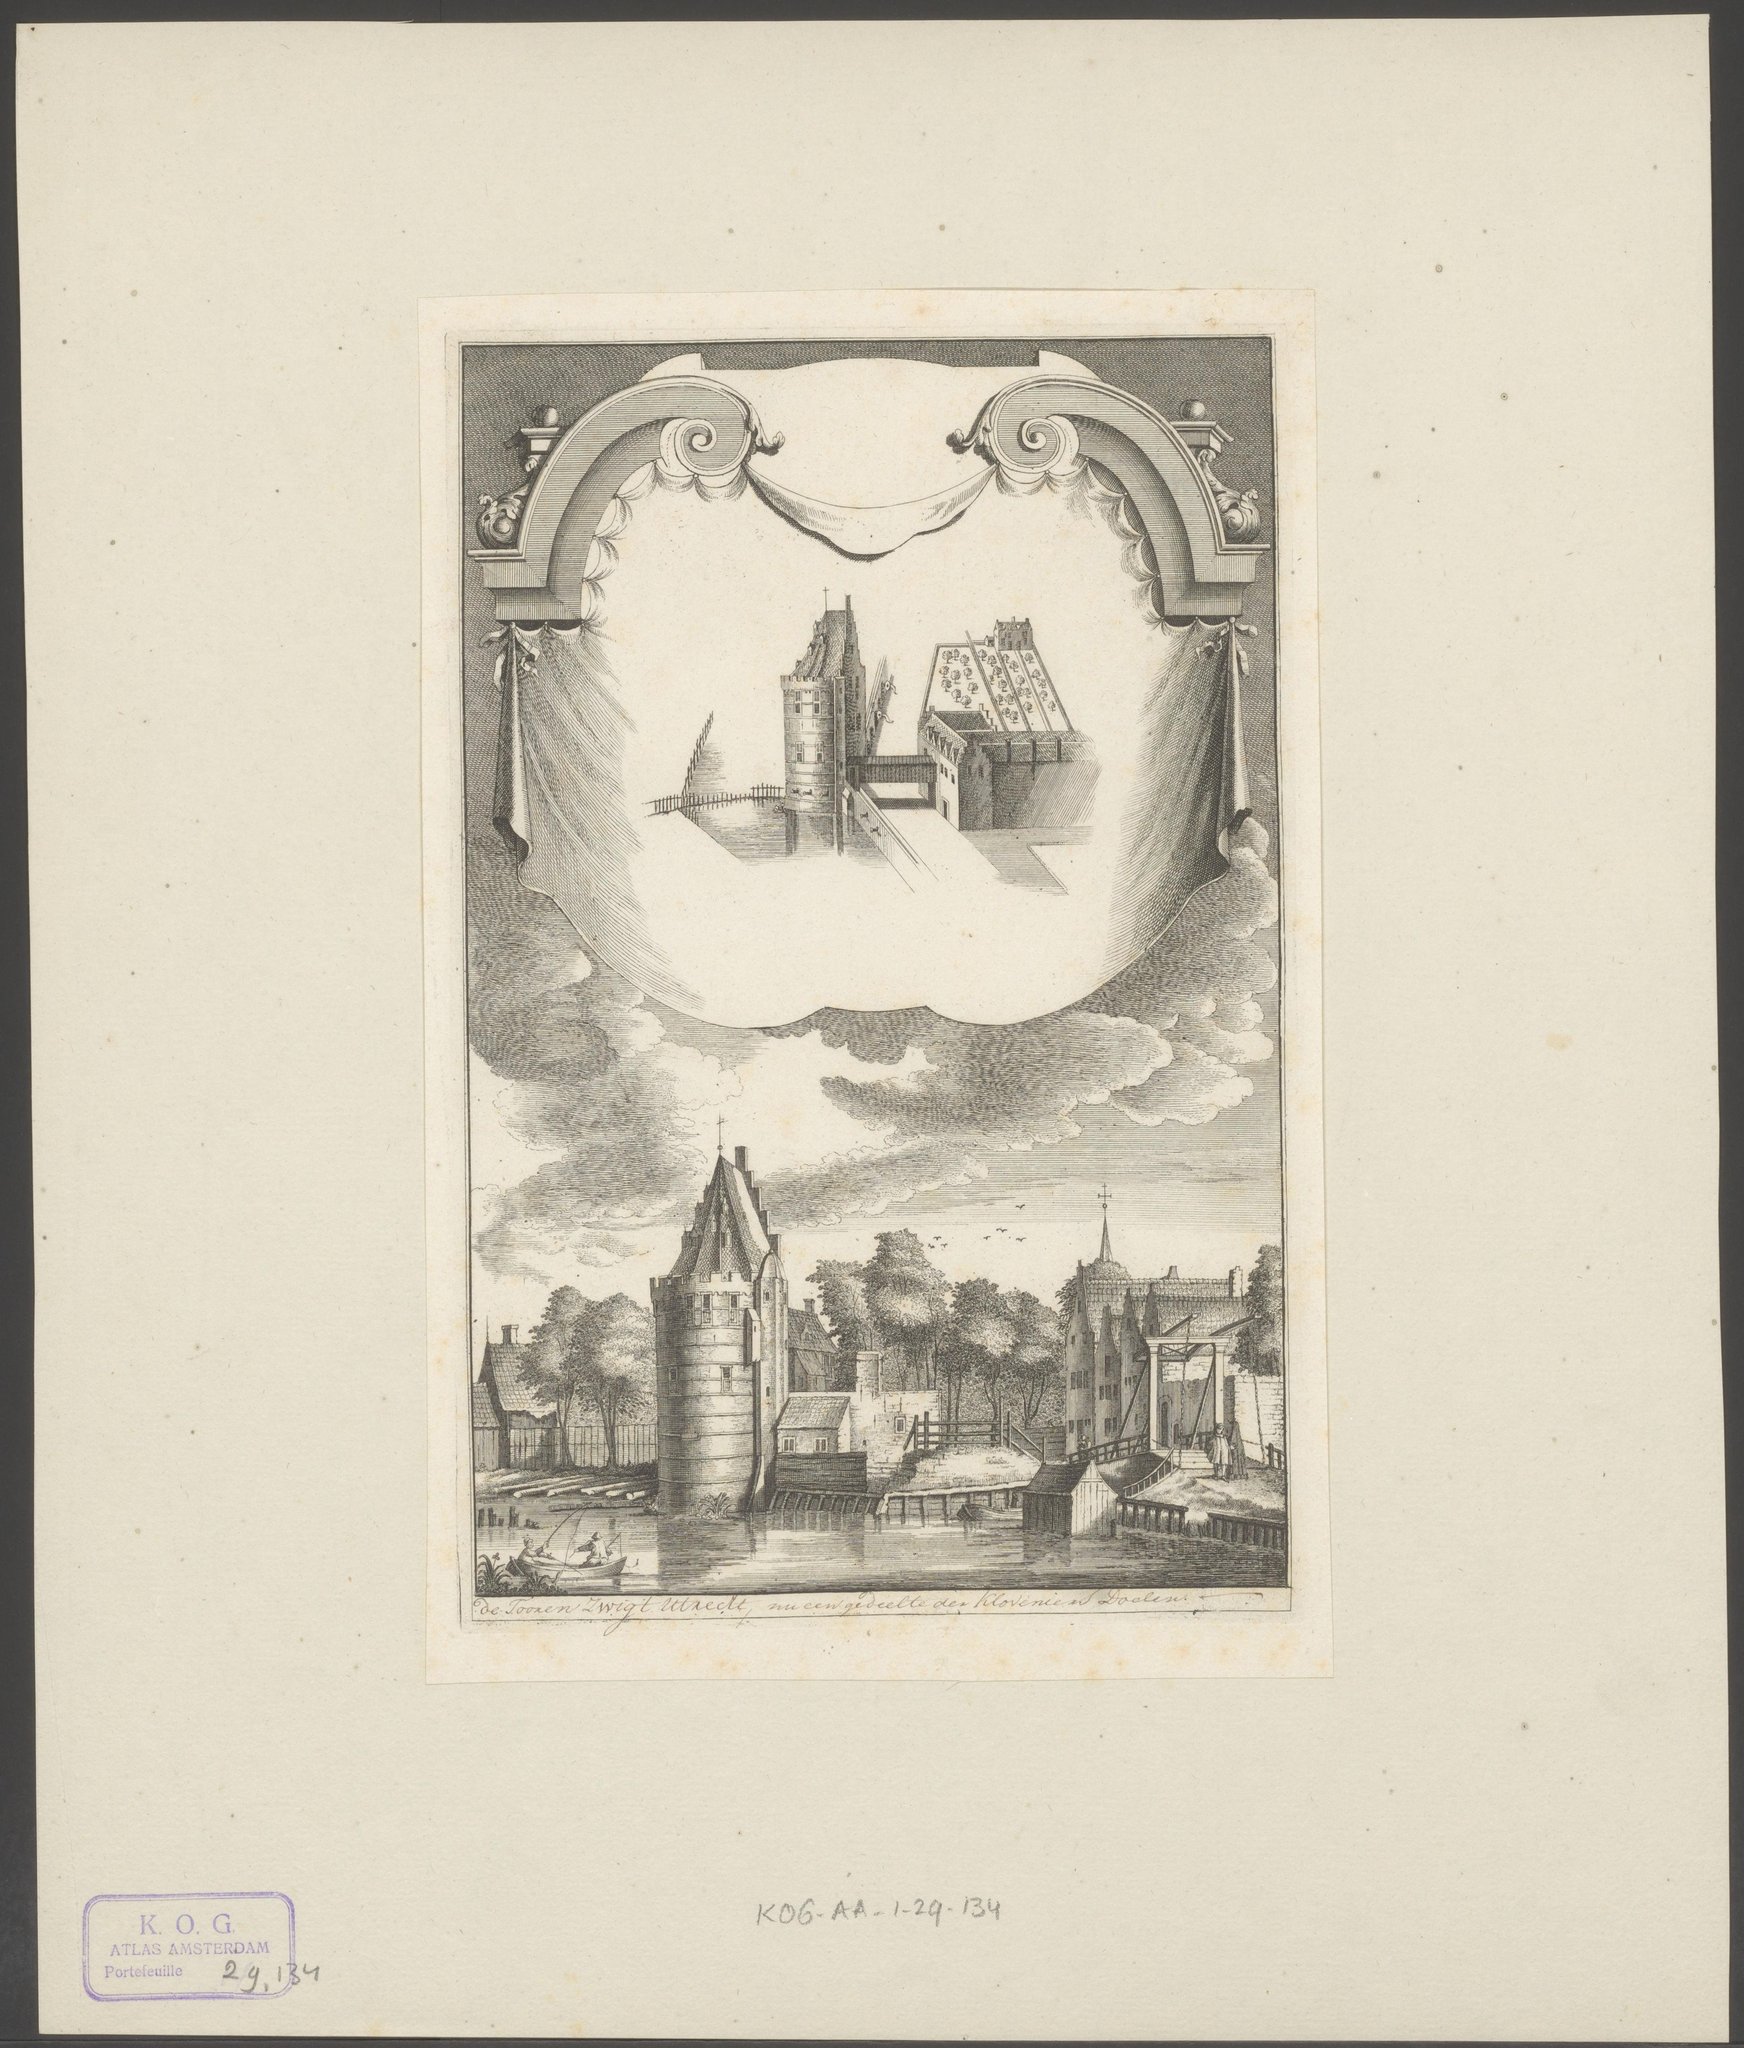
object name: print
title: Twee gezichten op de toren Swych Utrecht te Amsterdam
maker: jan goeree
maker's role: draughtsman, print maker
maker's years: 1670-1731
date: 1760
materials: paper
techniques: etching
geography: amsterdam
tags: towers ~ fortified city, rowing-boat, canoe, etc., canals, waters (in city) (+ city(-scape) with figures, staffage)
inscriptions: collector's mark: Lugt 1641b, inscription: ‘de Tooren Zwigt Utrecht, nu een gedeelte der Kloveniers Doelen’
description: Latere staat, met tekst, gebruikt in: Wagenaar, Jan. Amsterdam, in zyne opkomst, aanwas, geschiedenissen (...). Amsterdam: Isaak Tirion, 1760, dl. 1, p. 220. En in: Verzameling der fraaiste gezigten van Amsterdam in negen en zeventig afbeeldingen. Amsterdam en Harlingen: Petrus Conradi en Volkert van der Plaats, 1782.